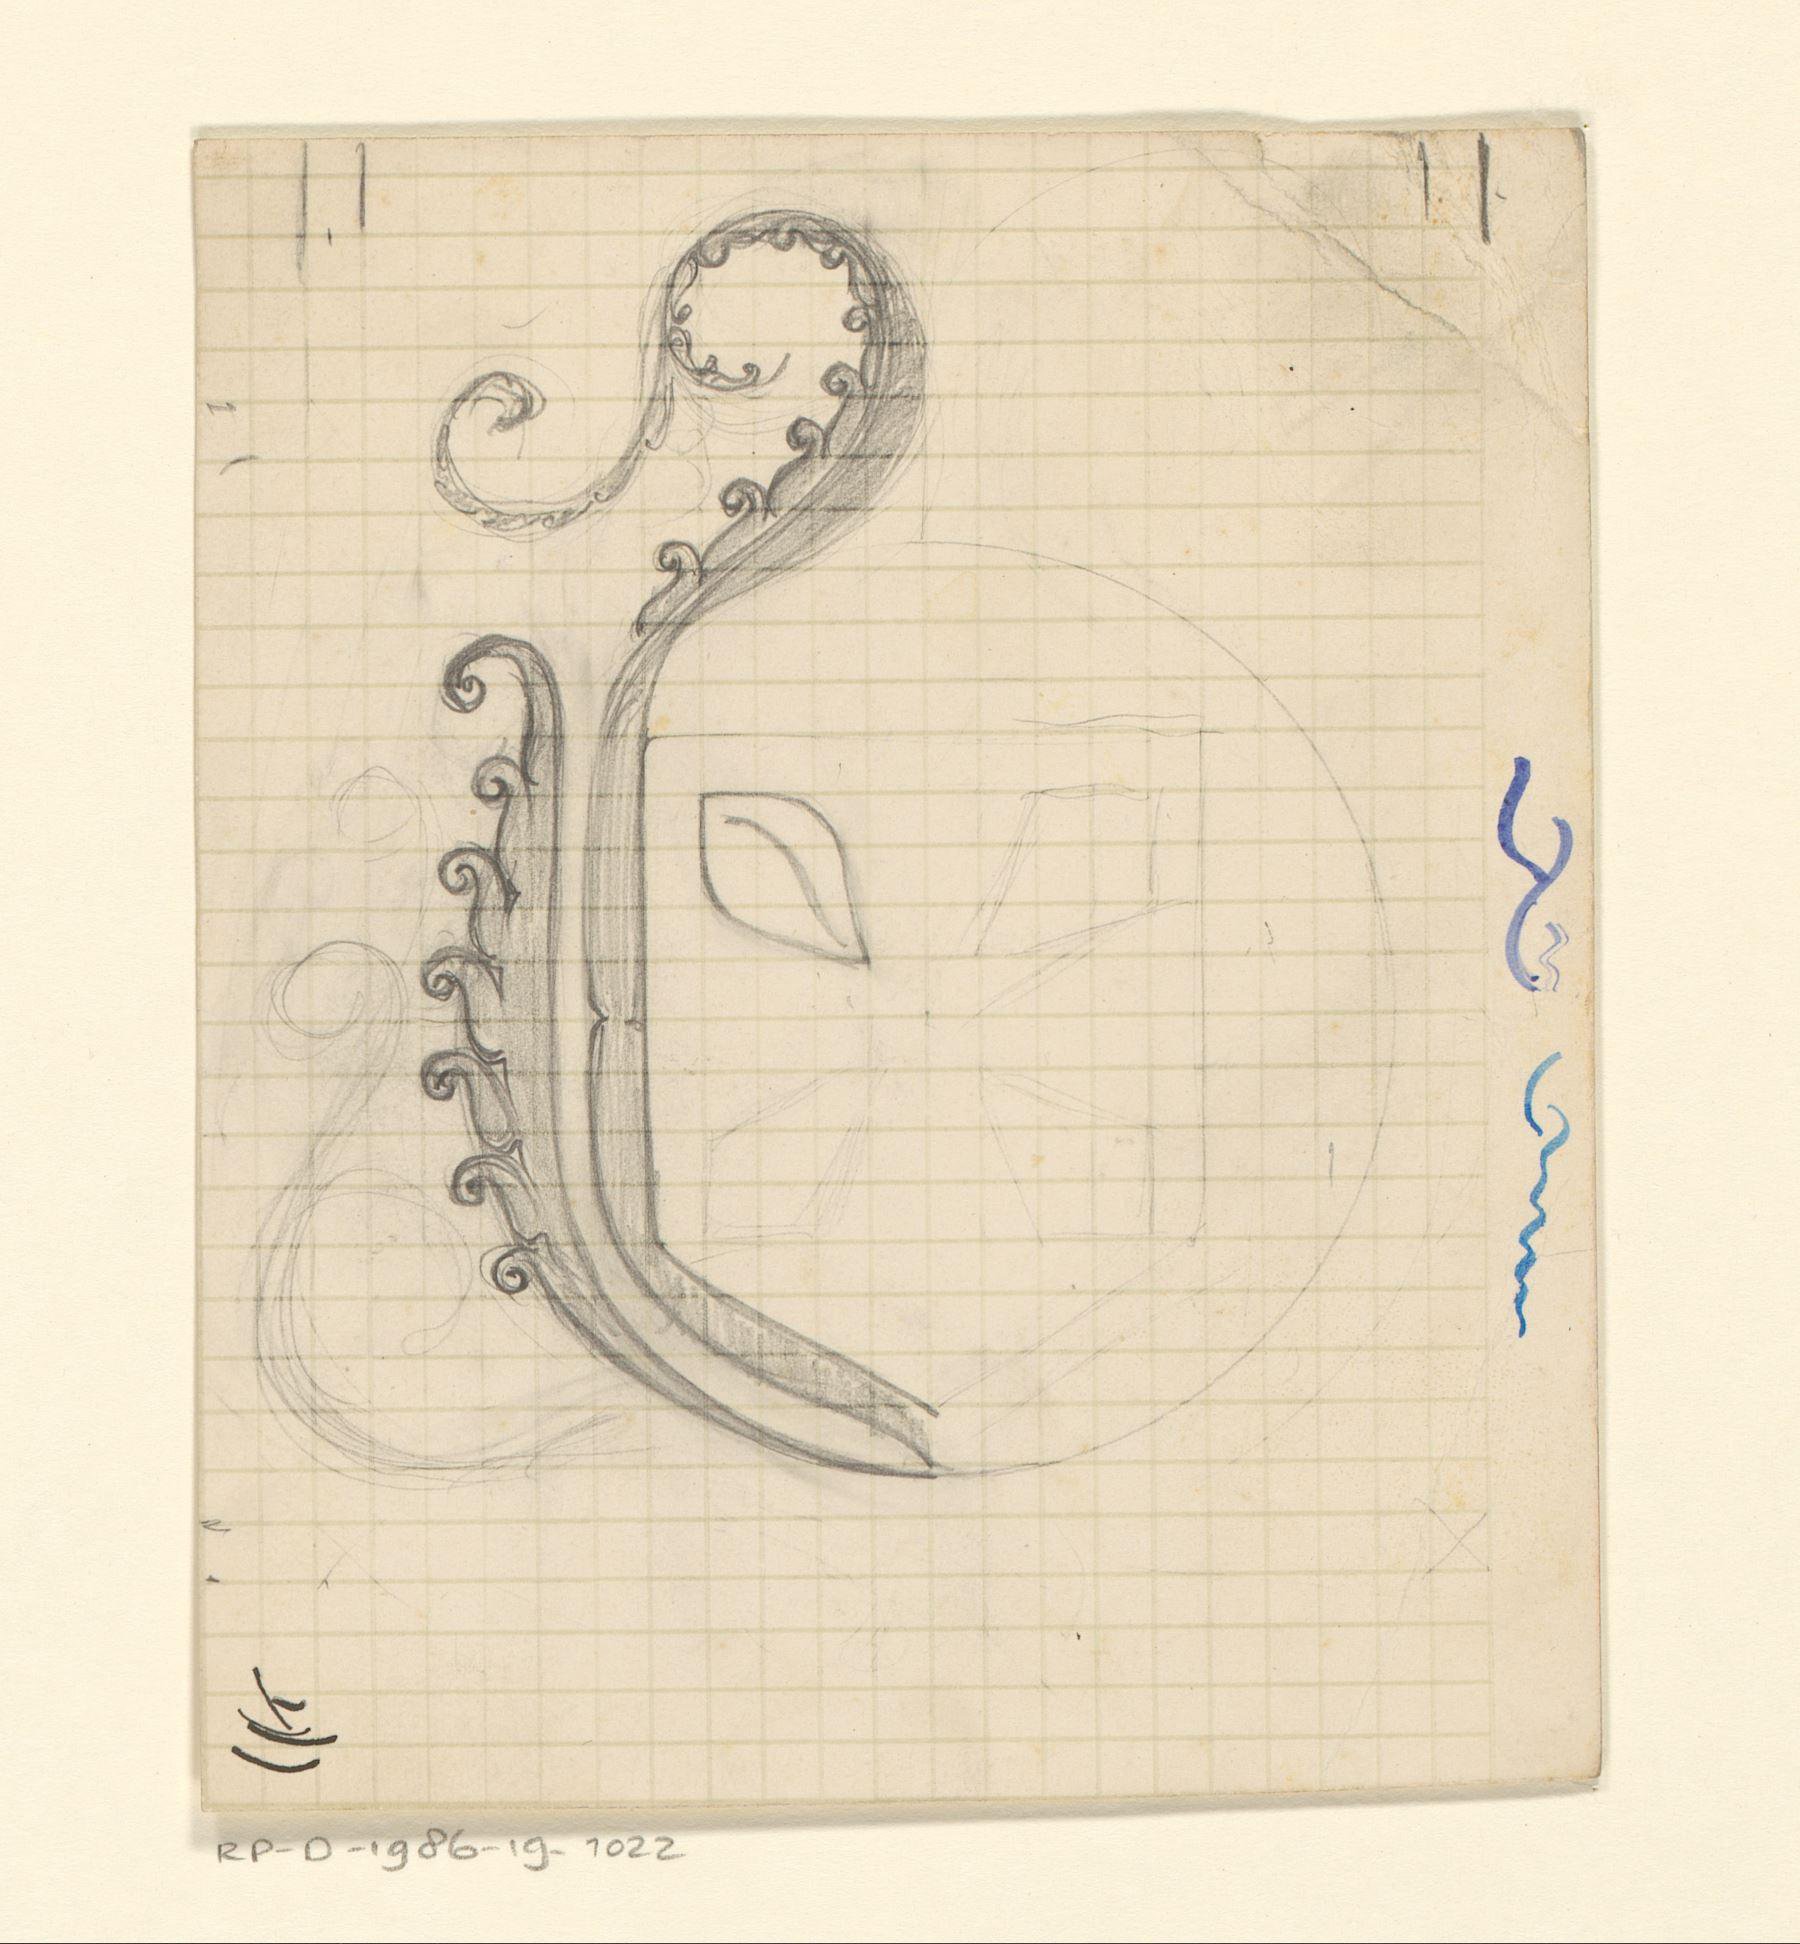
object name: design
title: Ontwerp met het wapen van Hilversum en ornamenten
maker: reinier willem petrus de vries (1874-1953)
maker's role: draughtsman, print maker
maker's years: 1874-1953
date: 1884-1952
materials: pencil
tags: coat of arms (as symbol of the state, etc.) (+ city; municipal), flowers ~ ornament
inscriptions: annotation, collector's mark: ‘R:MVS.’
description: Vermoedelijk een ontwerp voor: Ravesteijn, P.J. Gedenkboek Hilversum 1424-1924. Hilversum: Gemeente Hilversum, 1924.